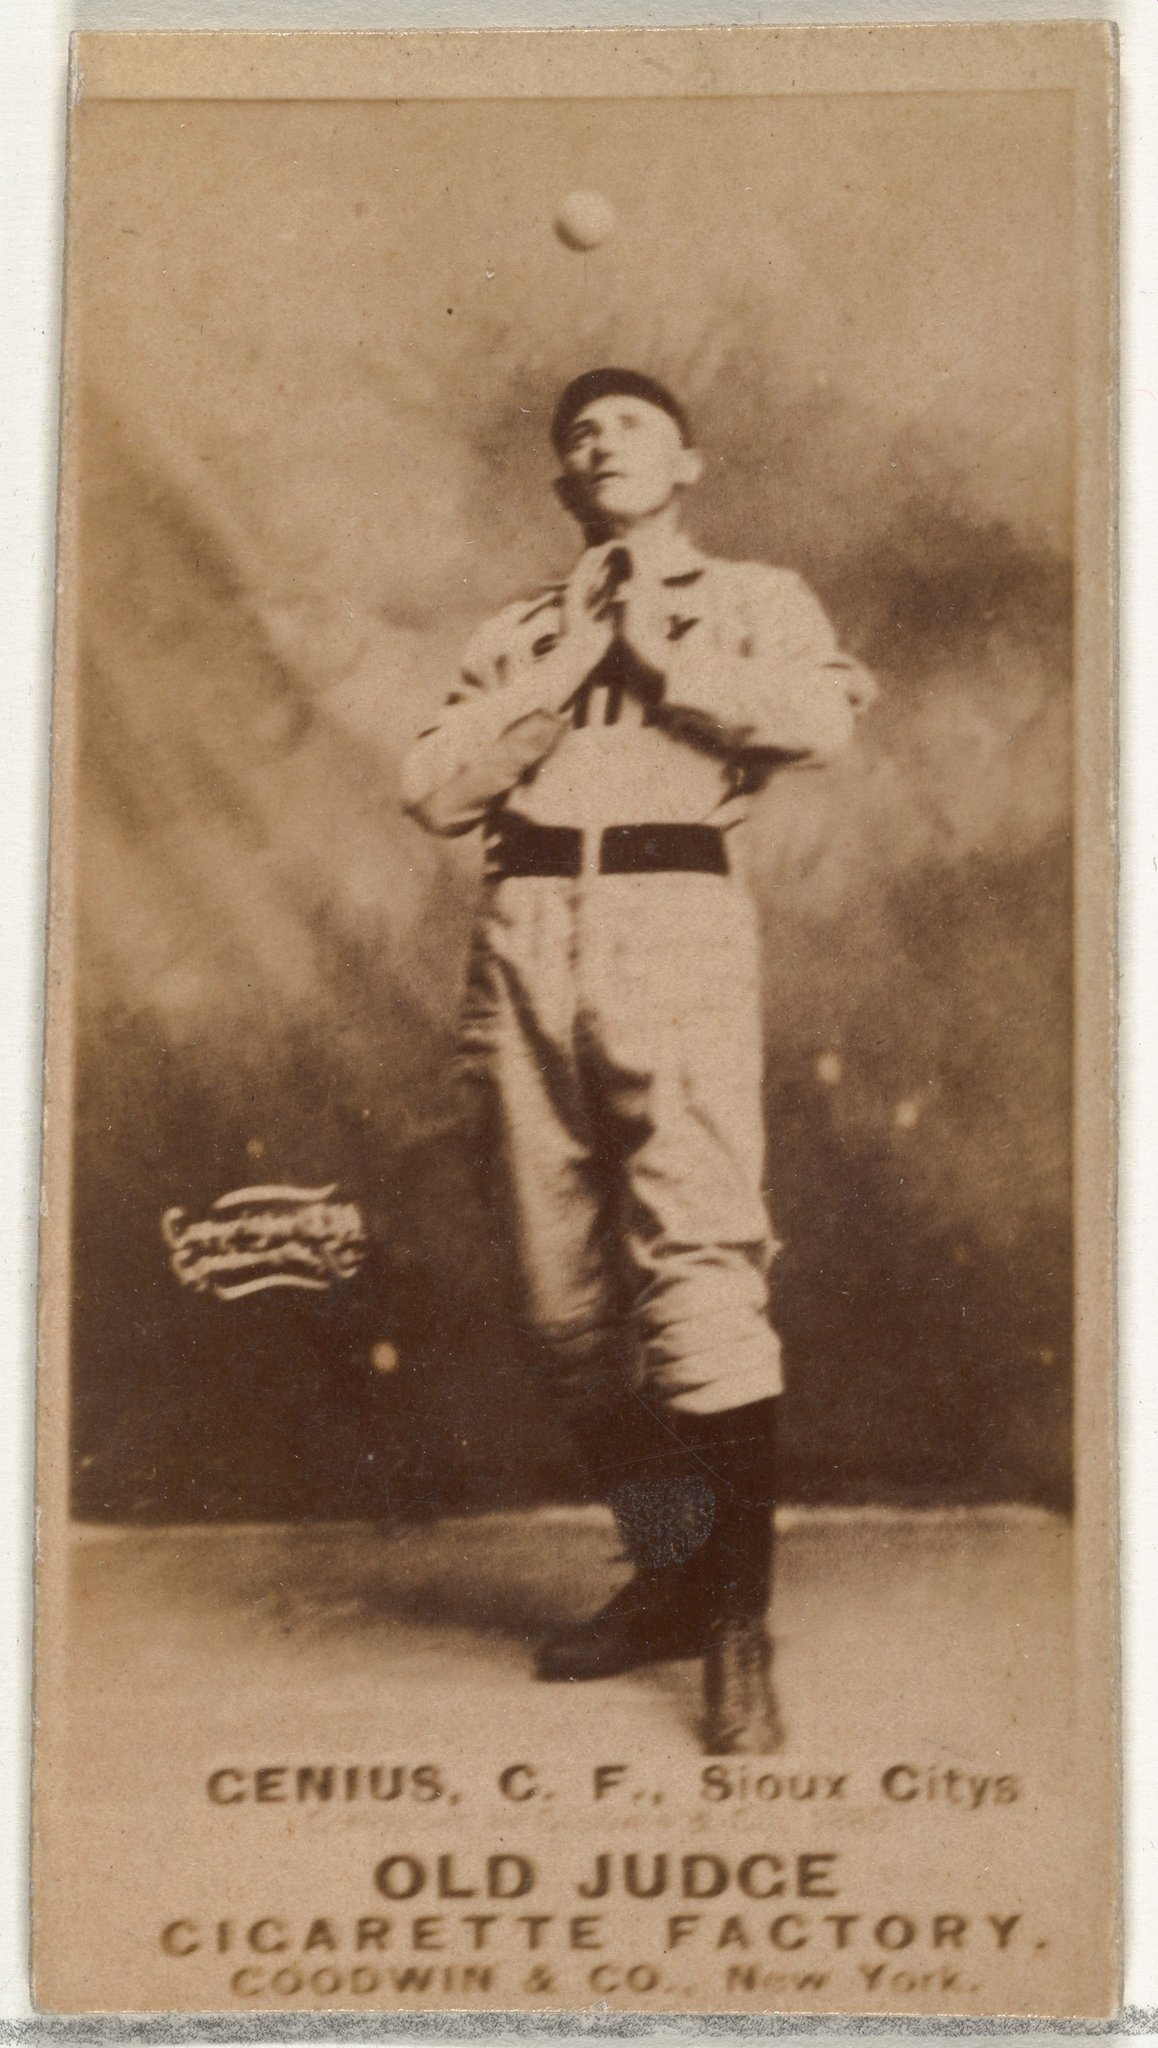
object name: baseball card, photograph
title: C. Frank Genins, Center Field, Sioux City Corn Huskers, from the Old Judge series (N172) for Old Judge Cigarettes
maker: goodwin & company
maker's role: publisher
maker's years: 1850-1950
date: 1888-1889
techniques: albumen silver print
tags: men,portraits,baseball,athletes